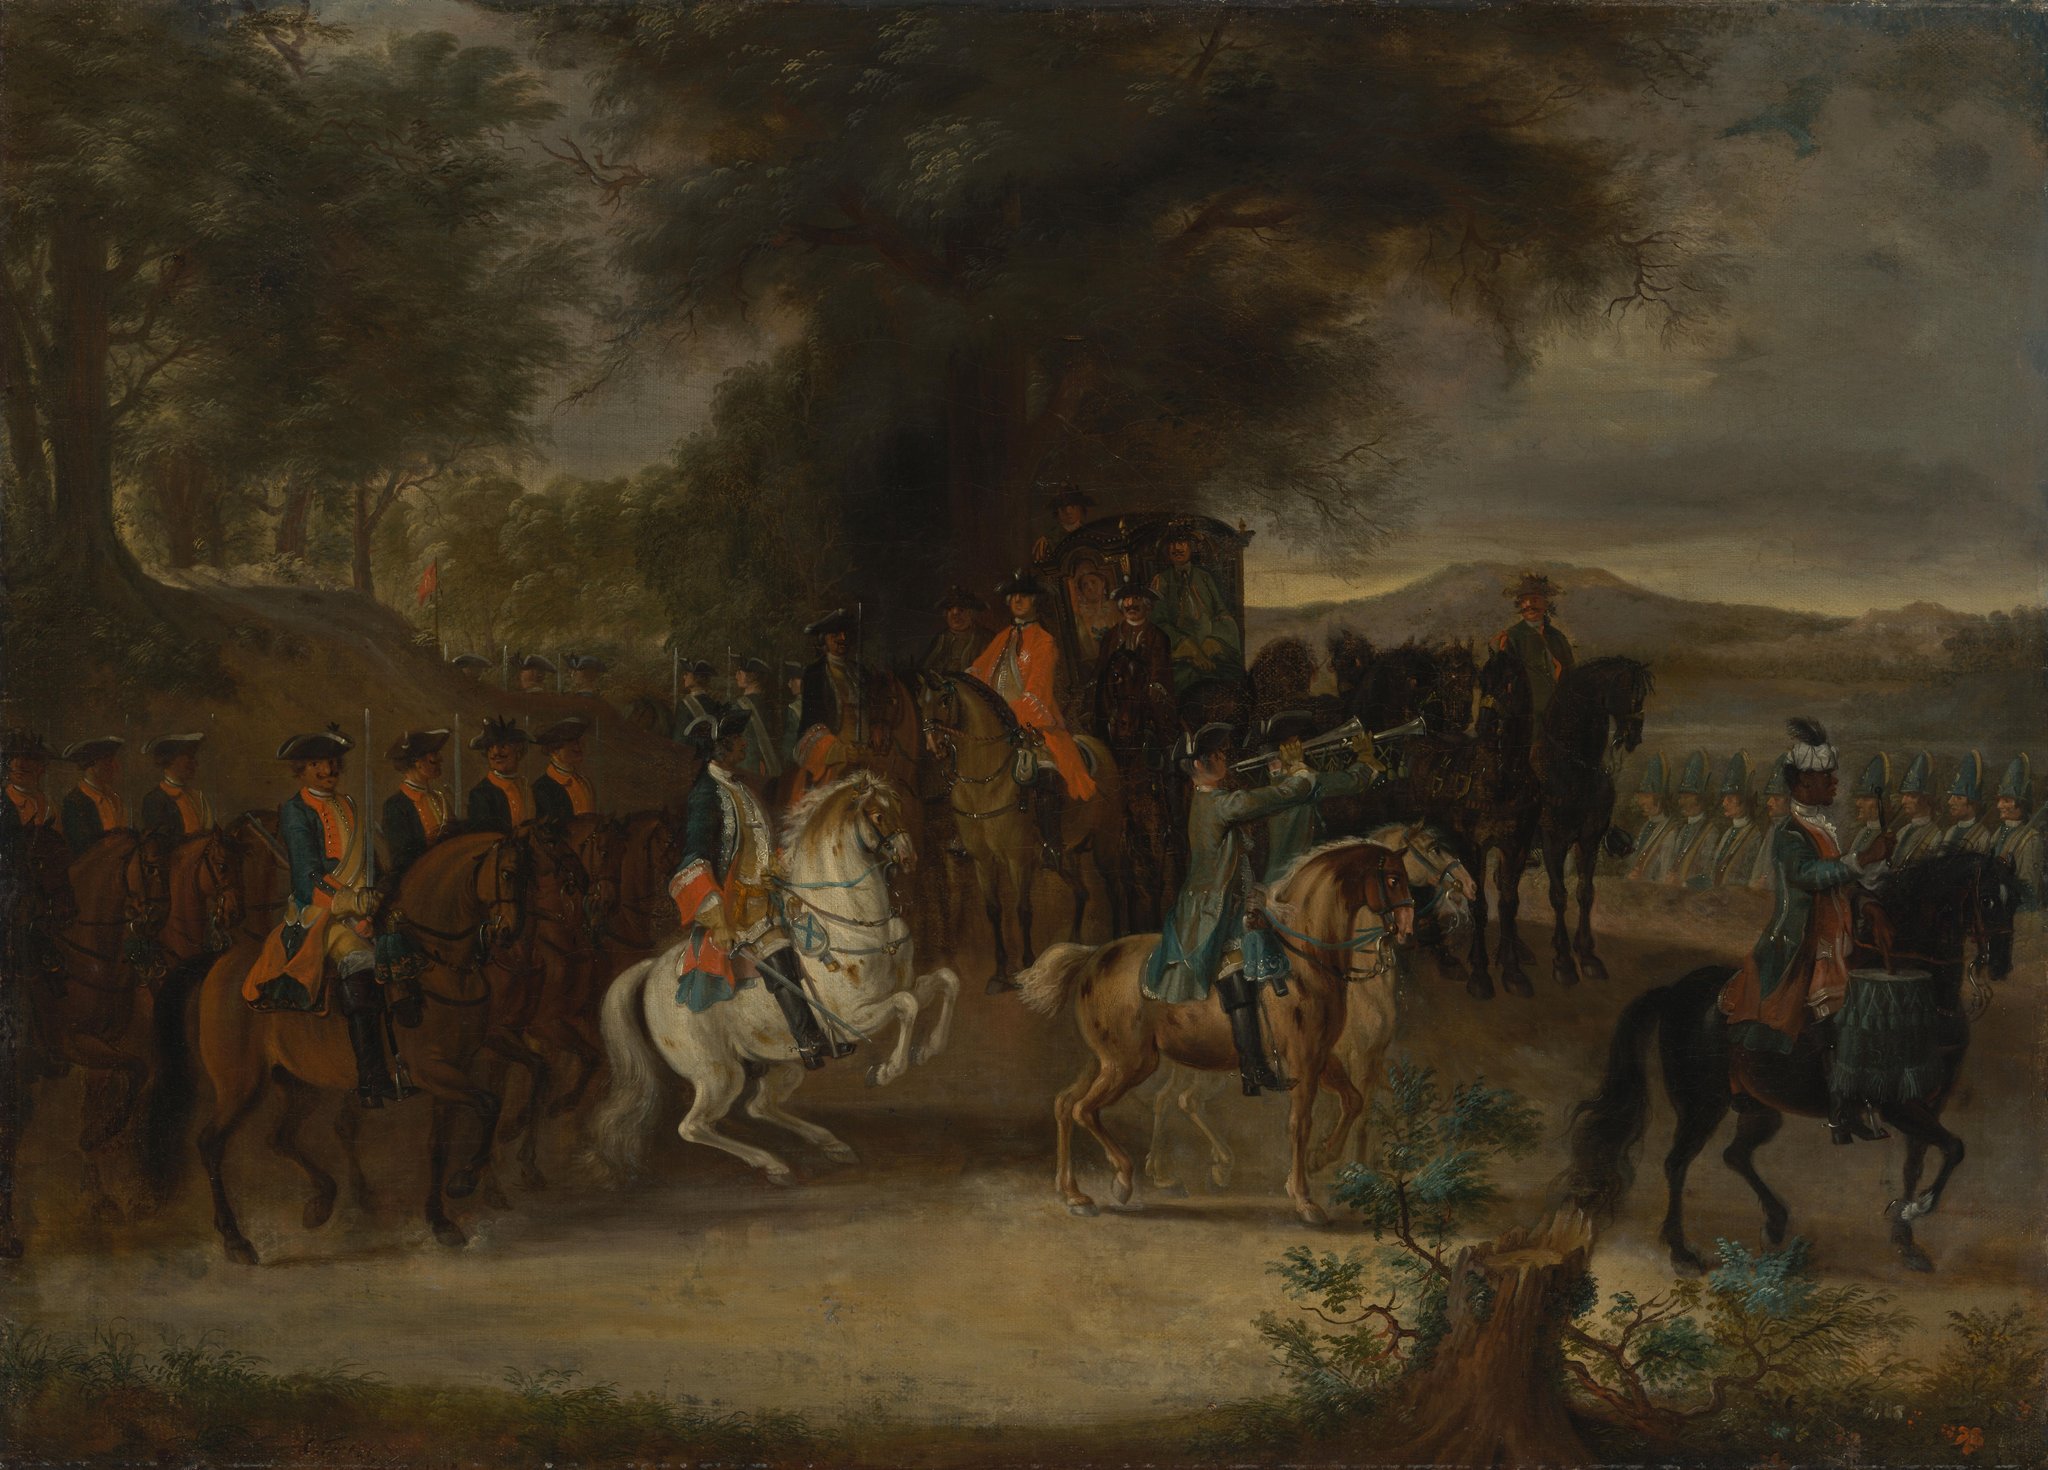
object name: painting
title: Inspection of a Cavalry Regiment, perhaps by William of Hesse-Homburg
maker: cornelis troost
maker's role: draughtsman, painter, print maker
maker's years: 1696-1750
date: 1742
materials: canvas, oil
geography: netherlands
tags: the hague, willem iv (prins van oranje-nassau), anna van hannover, review, inspection (of company, unit, troop)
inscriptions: signature and date: ‘C. Troost. 1742’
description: The proudly erect drummer leads the troops out while beating the marching pace on his drums. For Paulus the position of timpanist was a promotion compared to his previous employ as a servant. Yet in this painting the Black man is still depicted with a silver collar around his neck, even in this more prominent function.